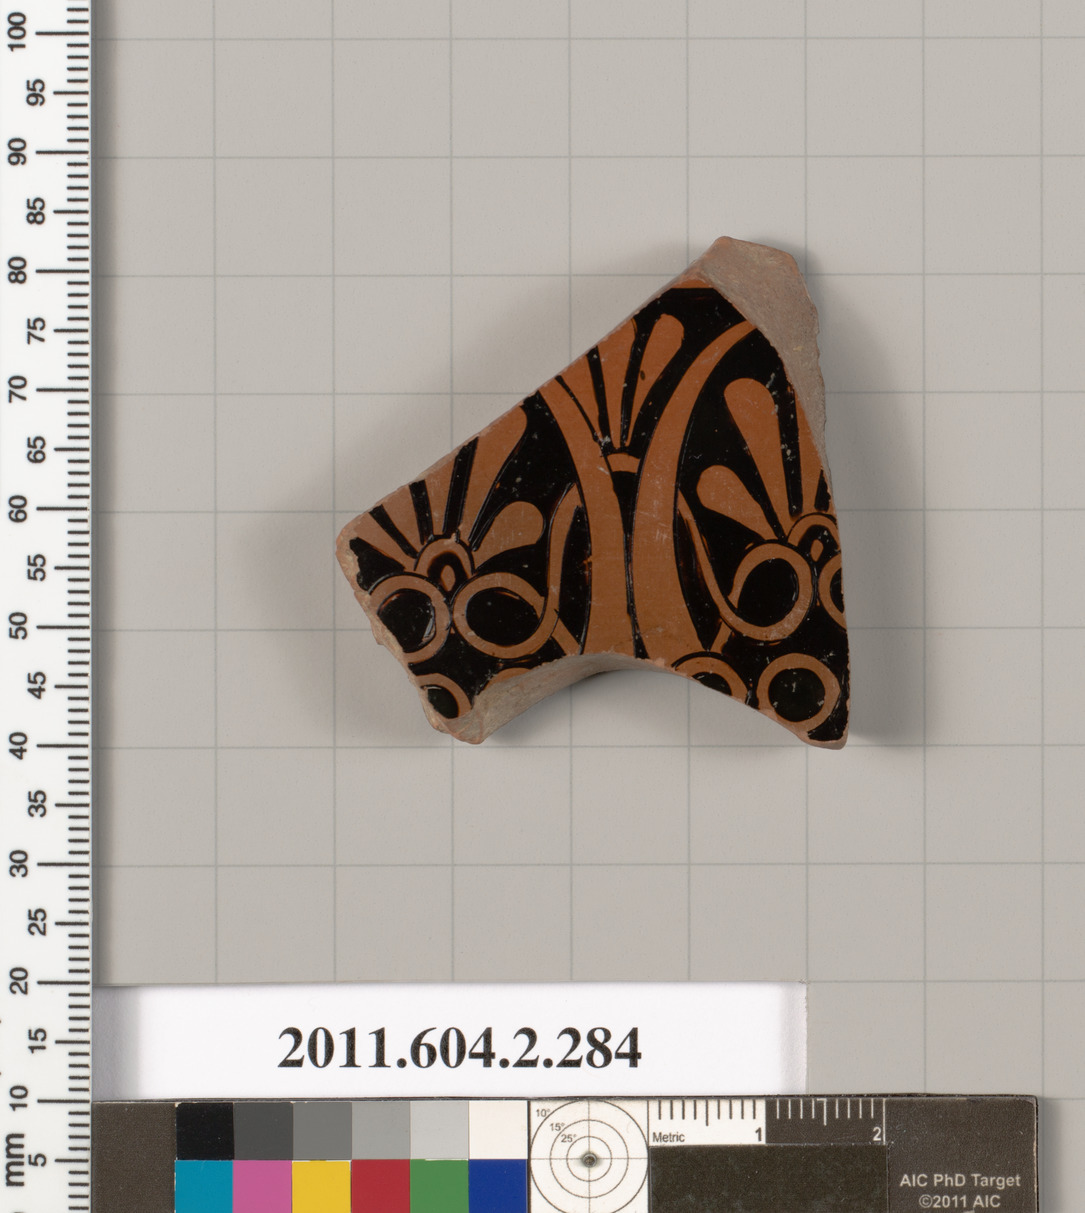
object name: volute krater fragment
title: Terracotta fragment of a volute-krater (bowl for mixing wine and water)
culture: greek, attic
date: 534-468 BCE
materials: terracotta